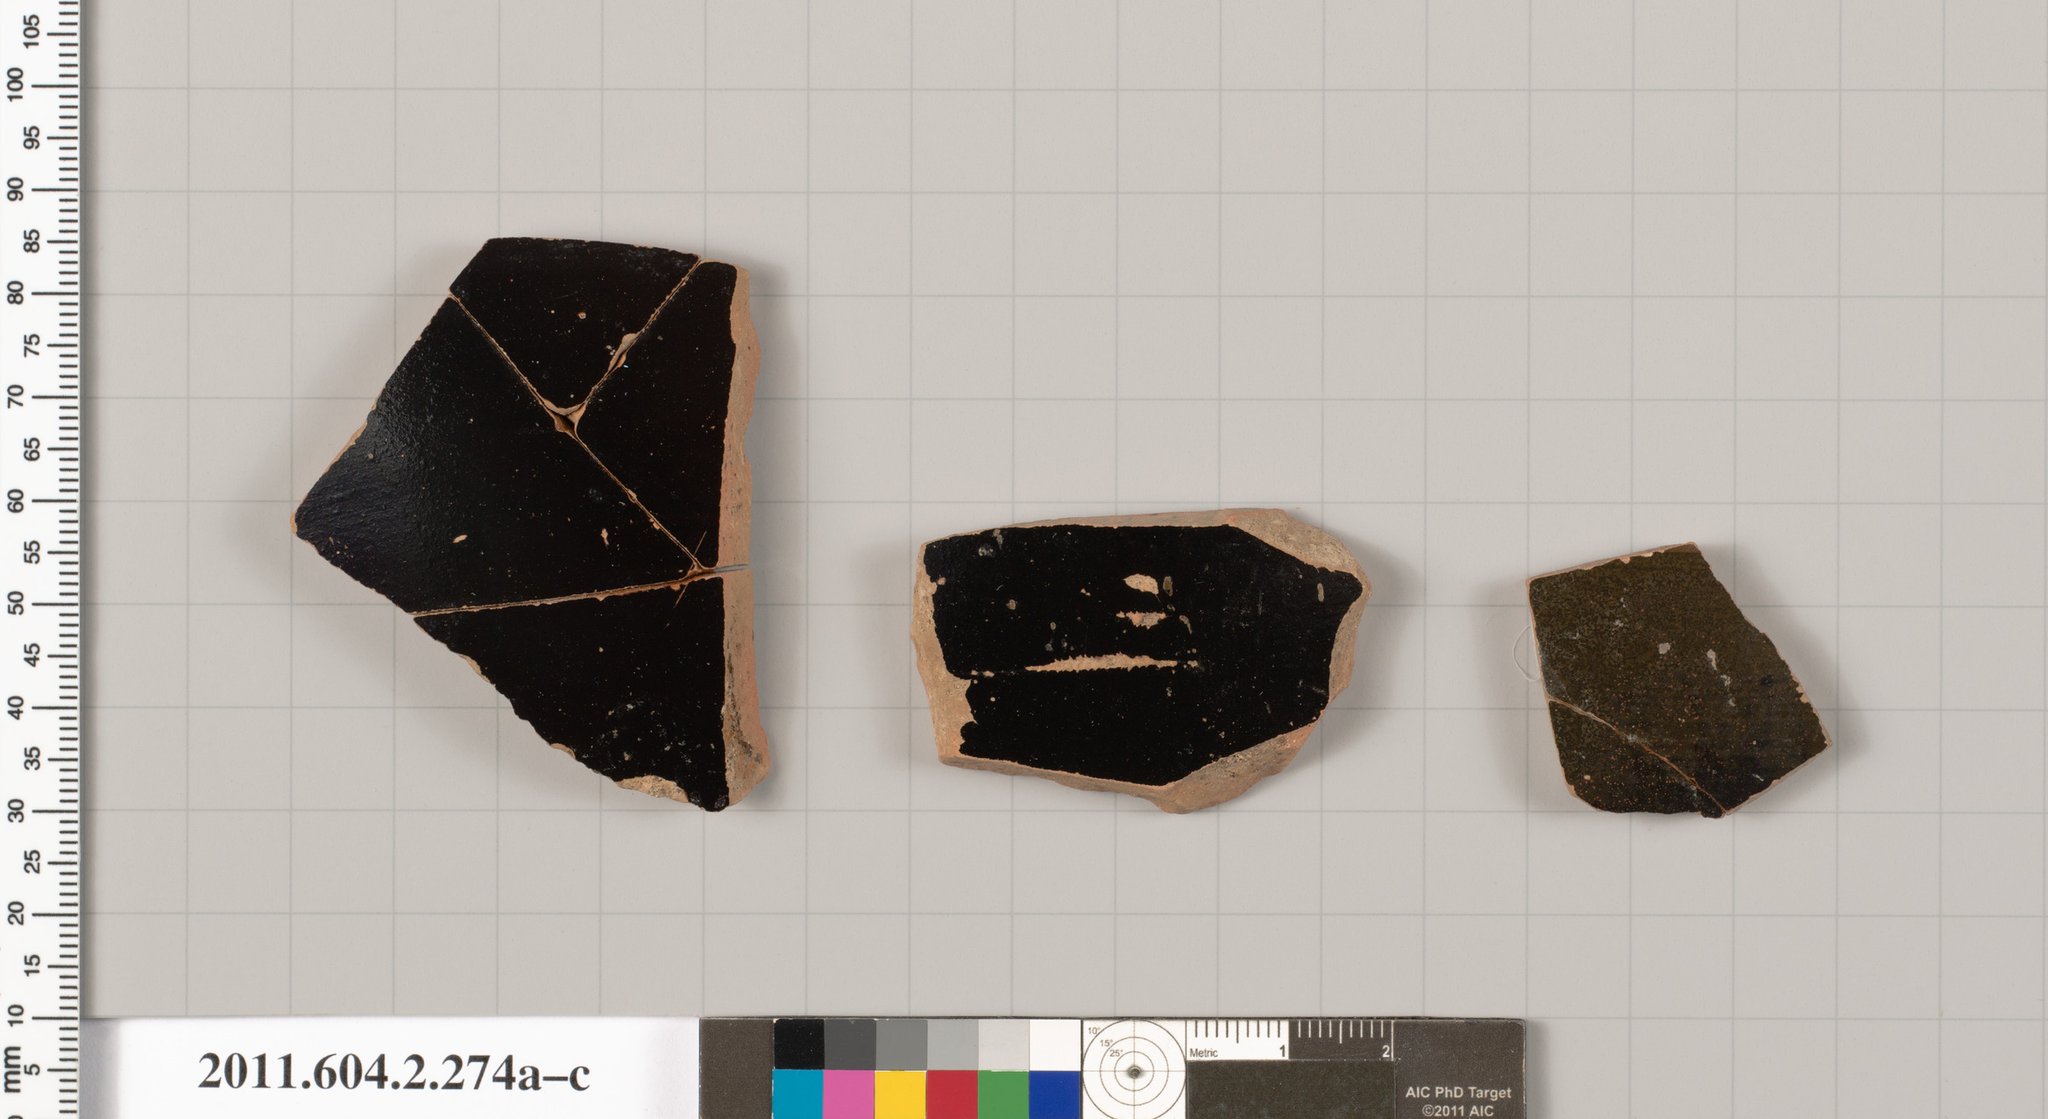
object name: stamnoi fragment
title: Terracotta fragments of stamnoi (jars)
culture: greek, attic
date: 600-401 BCE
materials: terracotta